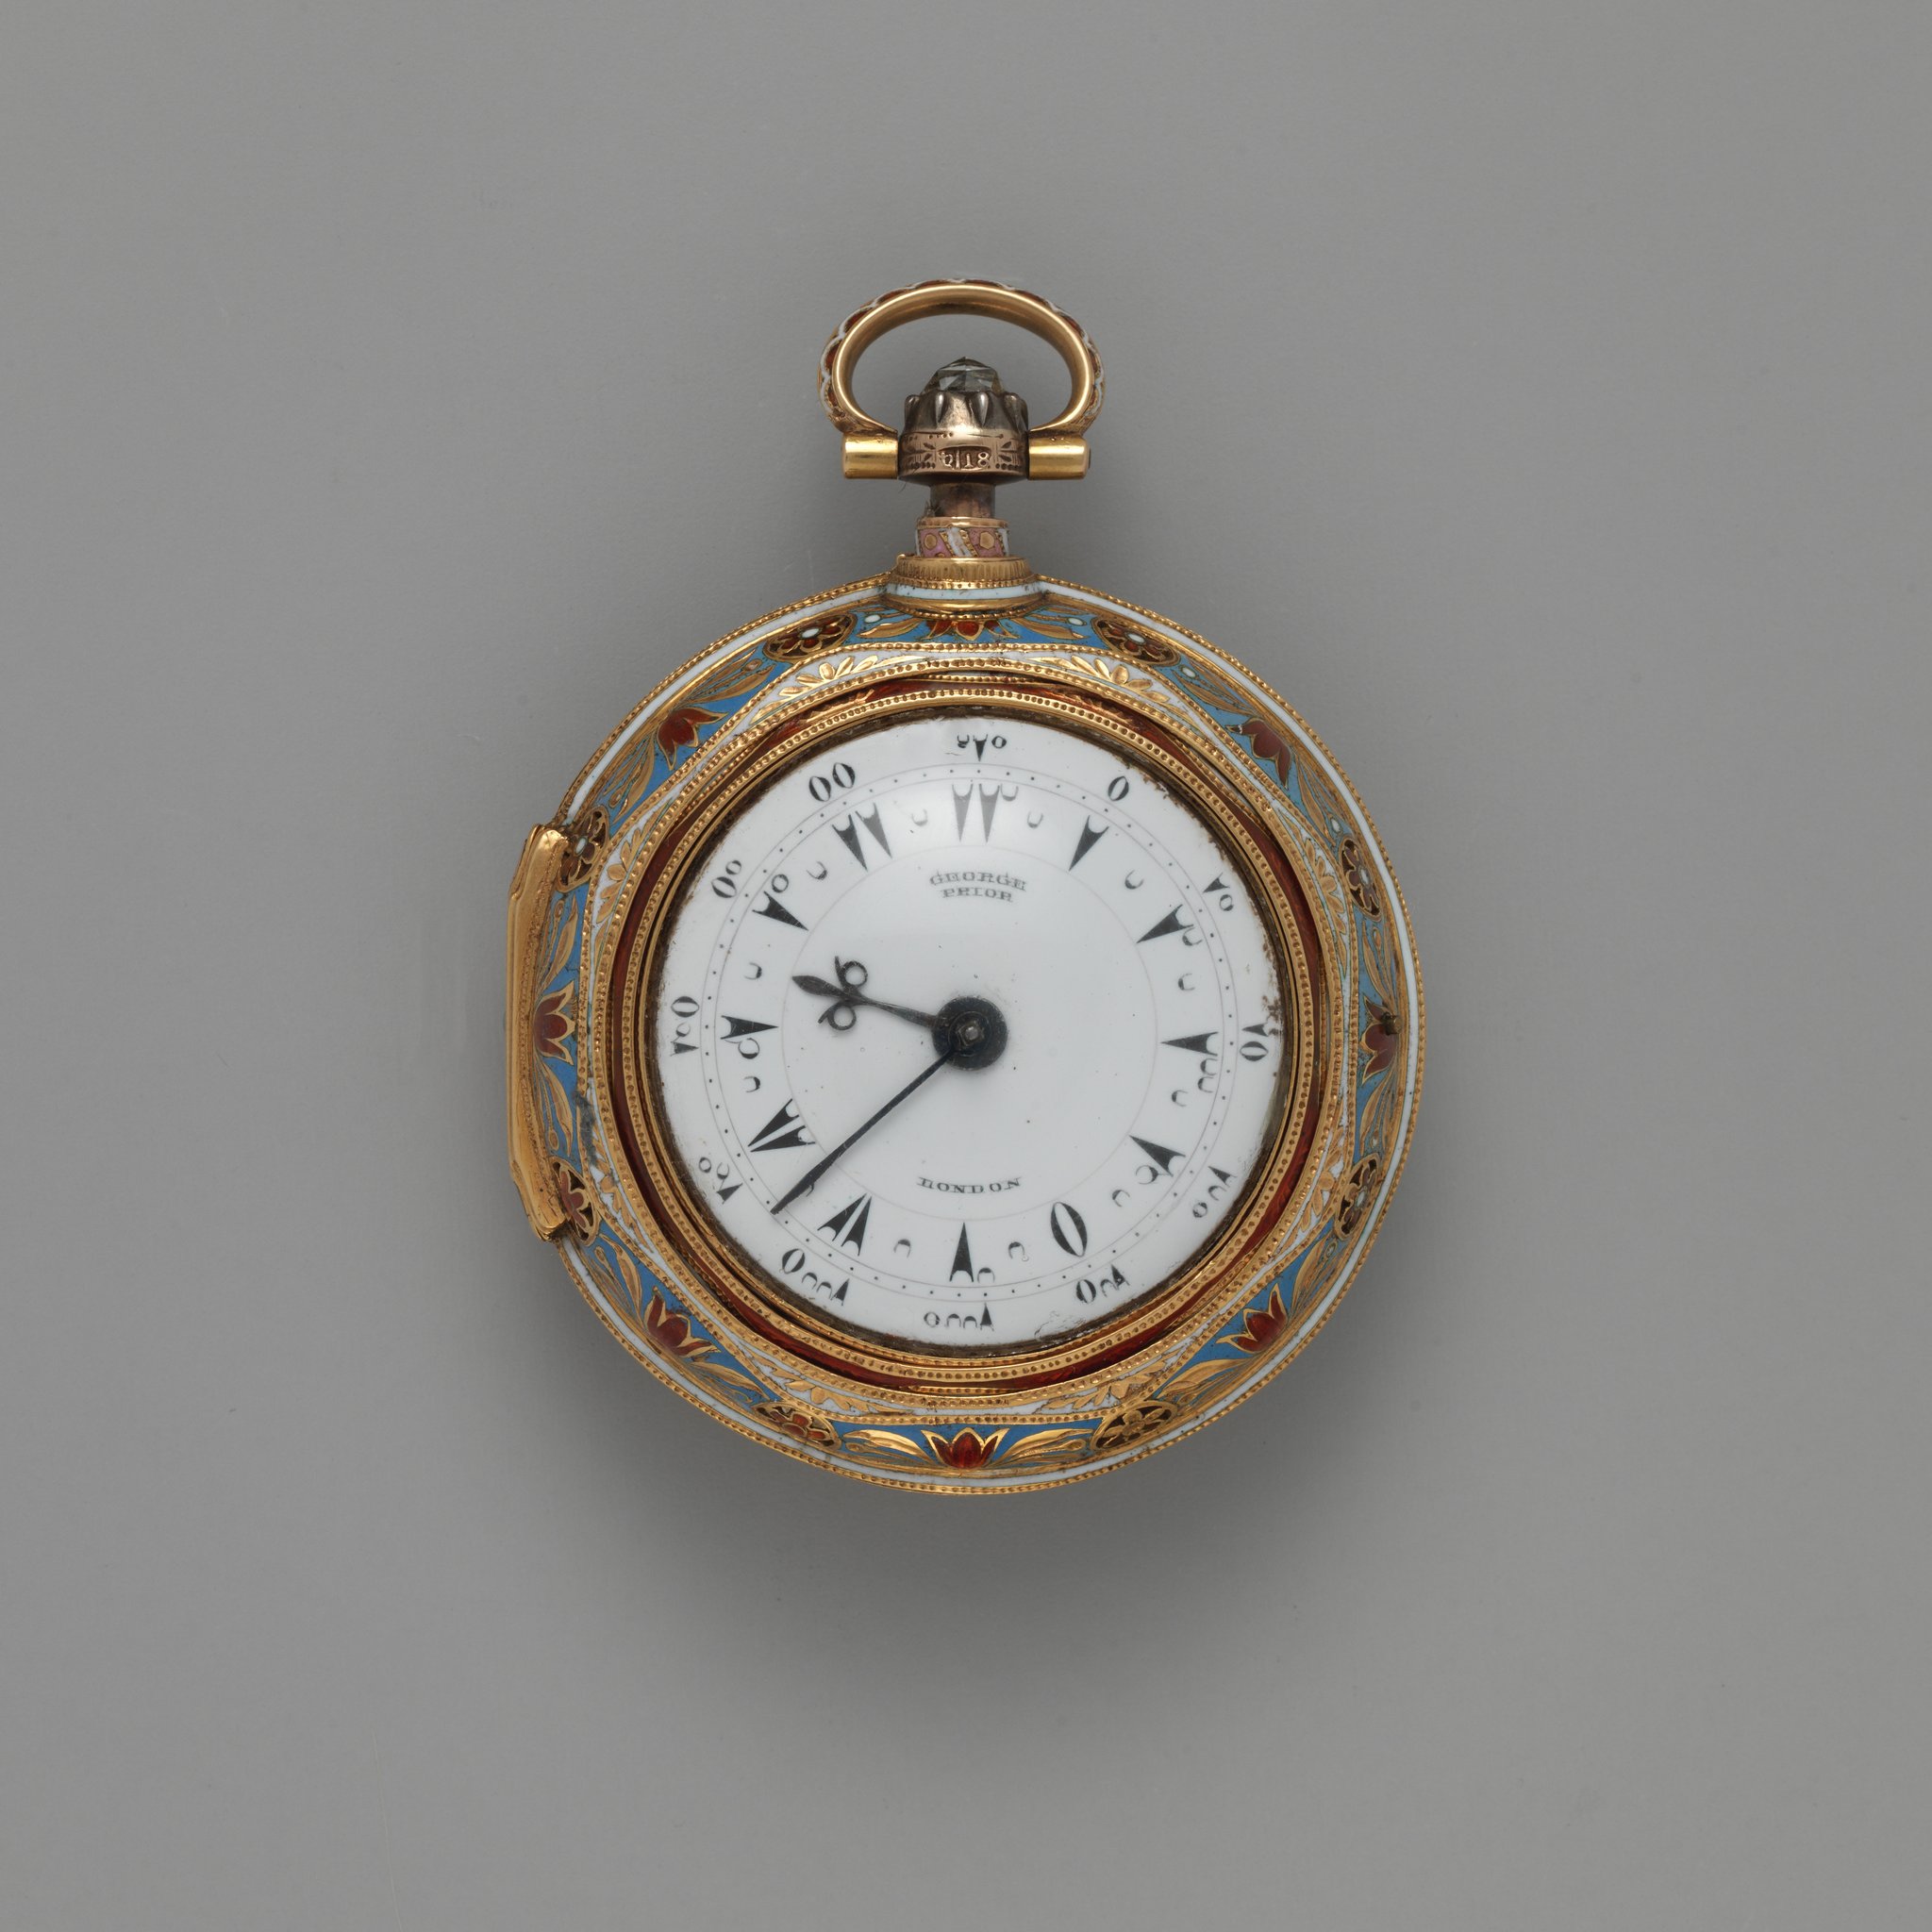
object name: repeating watch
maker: george prior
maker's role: maker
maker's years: 1800-1830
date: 1812-1813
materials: enamel, gold